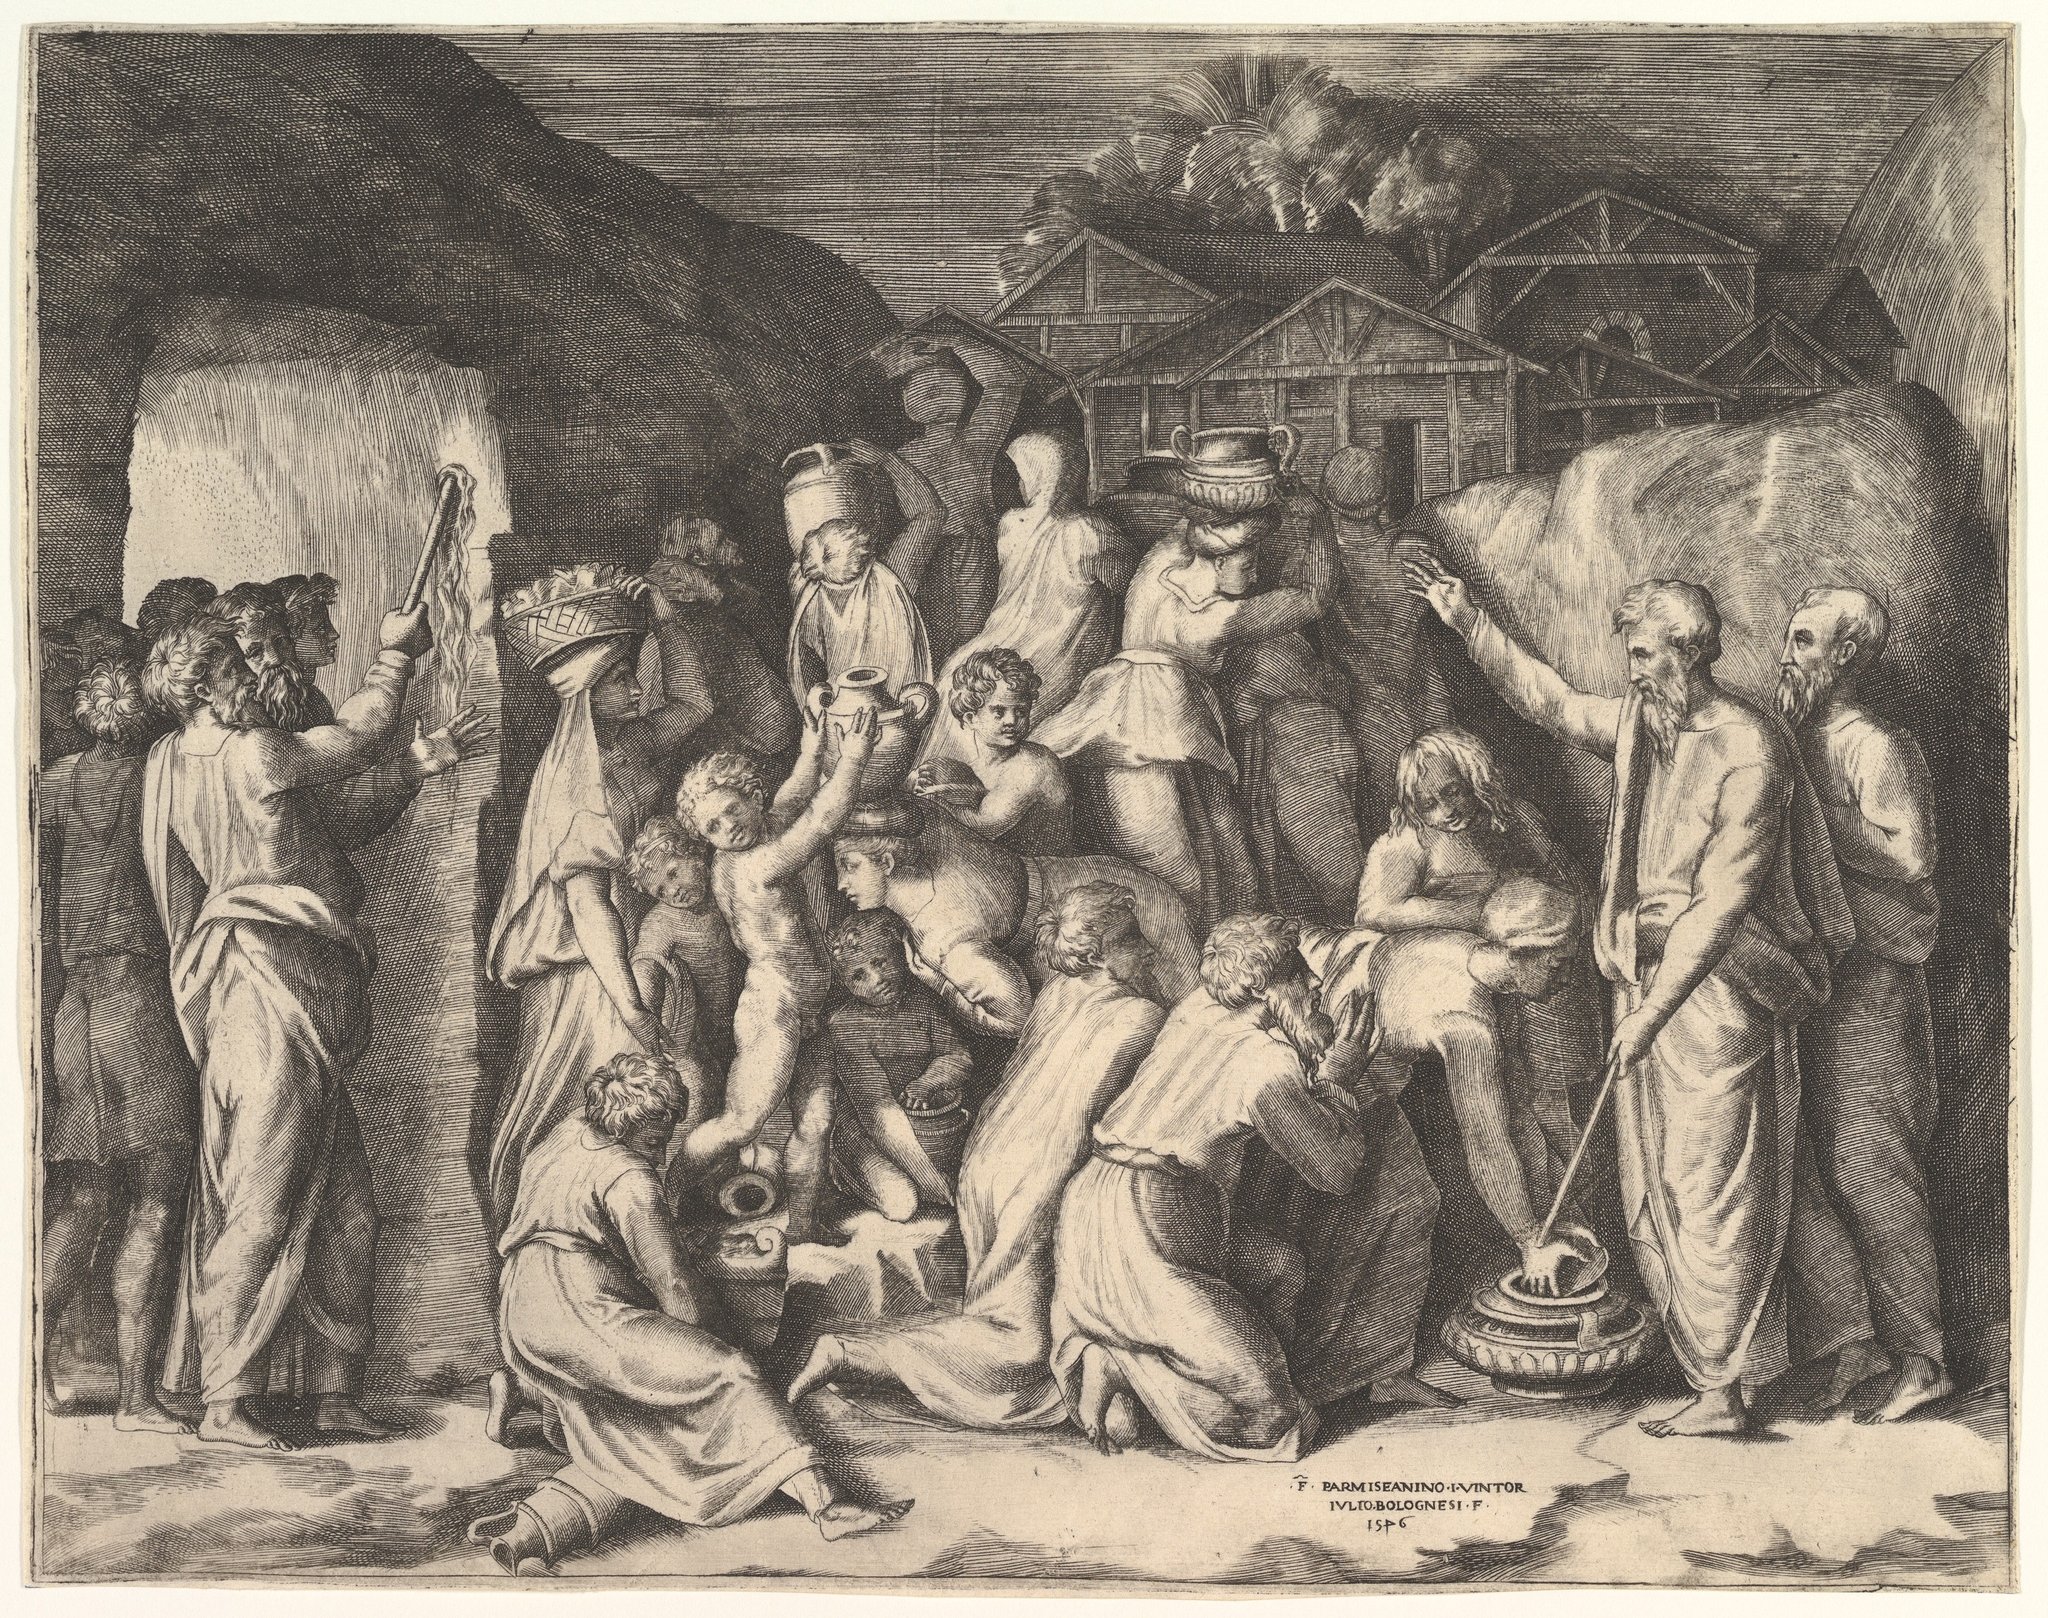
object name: print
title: Moses Telling the Israelites to Gather the Manna and Moses Striking the Rock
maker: giulio bonasone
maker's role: artist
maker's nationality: italian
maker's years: 1510-1576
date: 1530-1560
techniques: engraving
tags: men,women,moses,manna